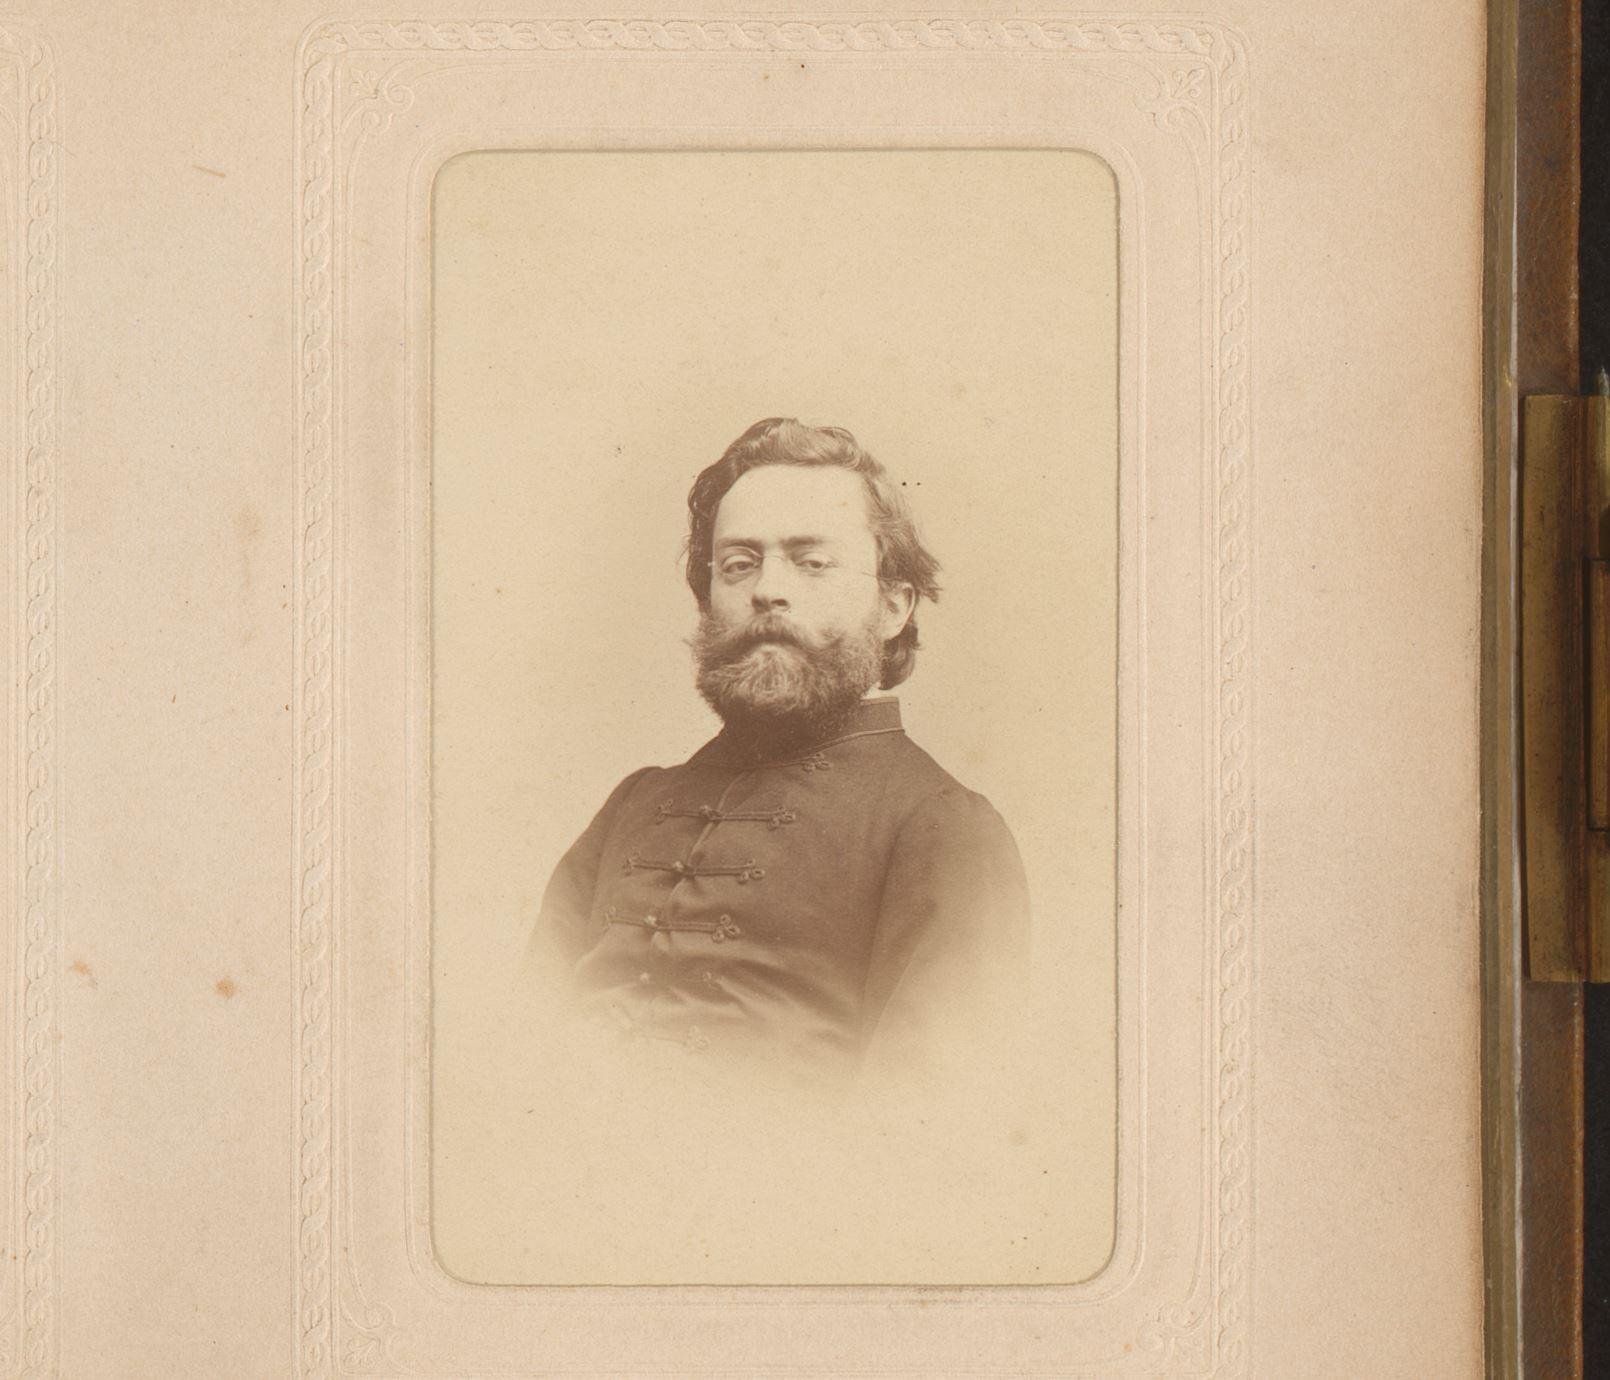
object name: album leaf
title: Portret van een man met snor, baard en bril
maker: a. stretti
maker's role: fotograaf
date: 1850-1900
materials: cardboard, photographic support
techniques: albumen print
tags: eyeglasses, spectacles, moustache, historical persons, beard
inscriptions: number: ‘269’, inscription: ‘A. STRETTI’